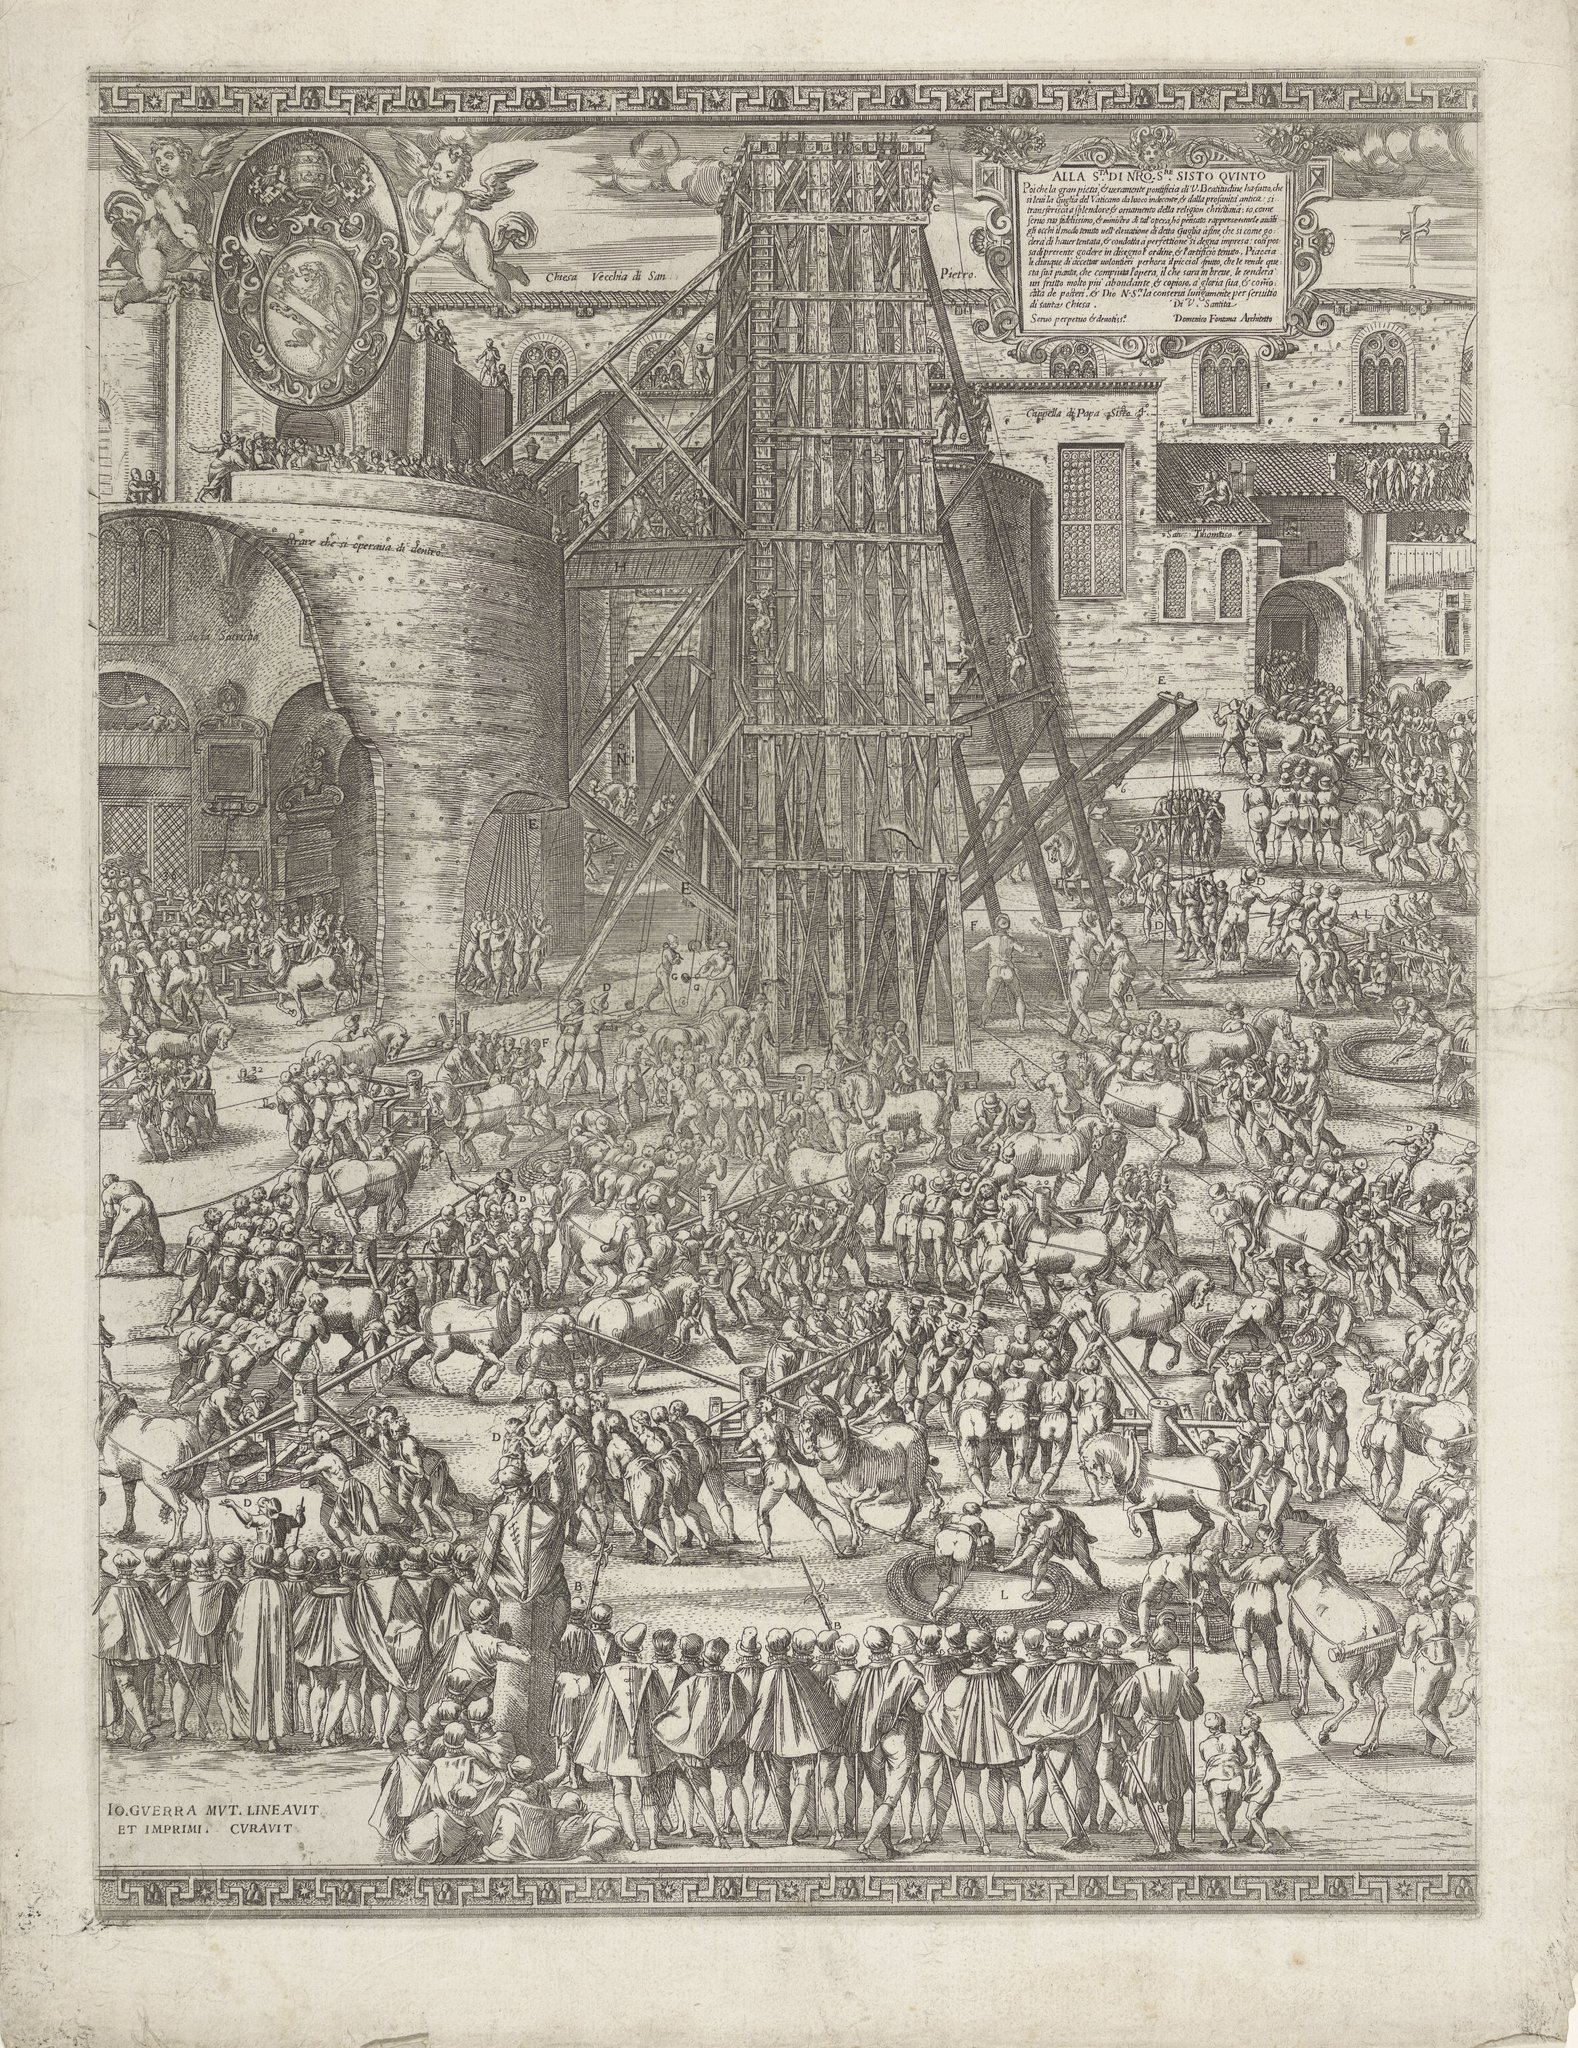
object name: print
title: De oprichting van de obelisk op het St. Pietersplein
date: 1586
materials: paper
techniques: engraving, etching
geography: rome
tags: switzerland, naples, domenico fontana, obelisk, needle, historical persons, roman catholic church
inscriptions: collector's mark: Lugt 2228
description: Mannen en paarden zijn voor de Sint-Pietersbasiliek bezig met het oprichten van de Vaticaanse Obelisk (in 1586) op het St. Pietersplein. Linksonder een verklarende lijst met nummers en letters en het portret van Domenico Fontana, de architect die de hele verplaatsing en oprichting van de obelisk overzag. Voorstelling gevat in een sierlijst.